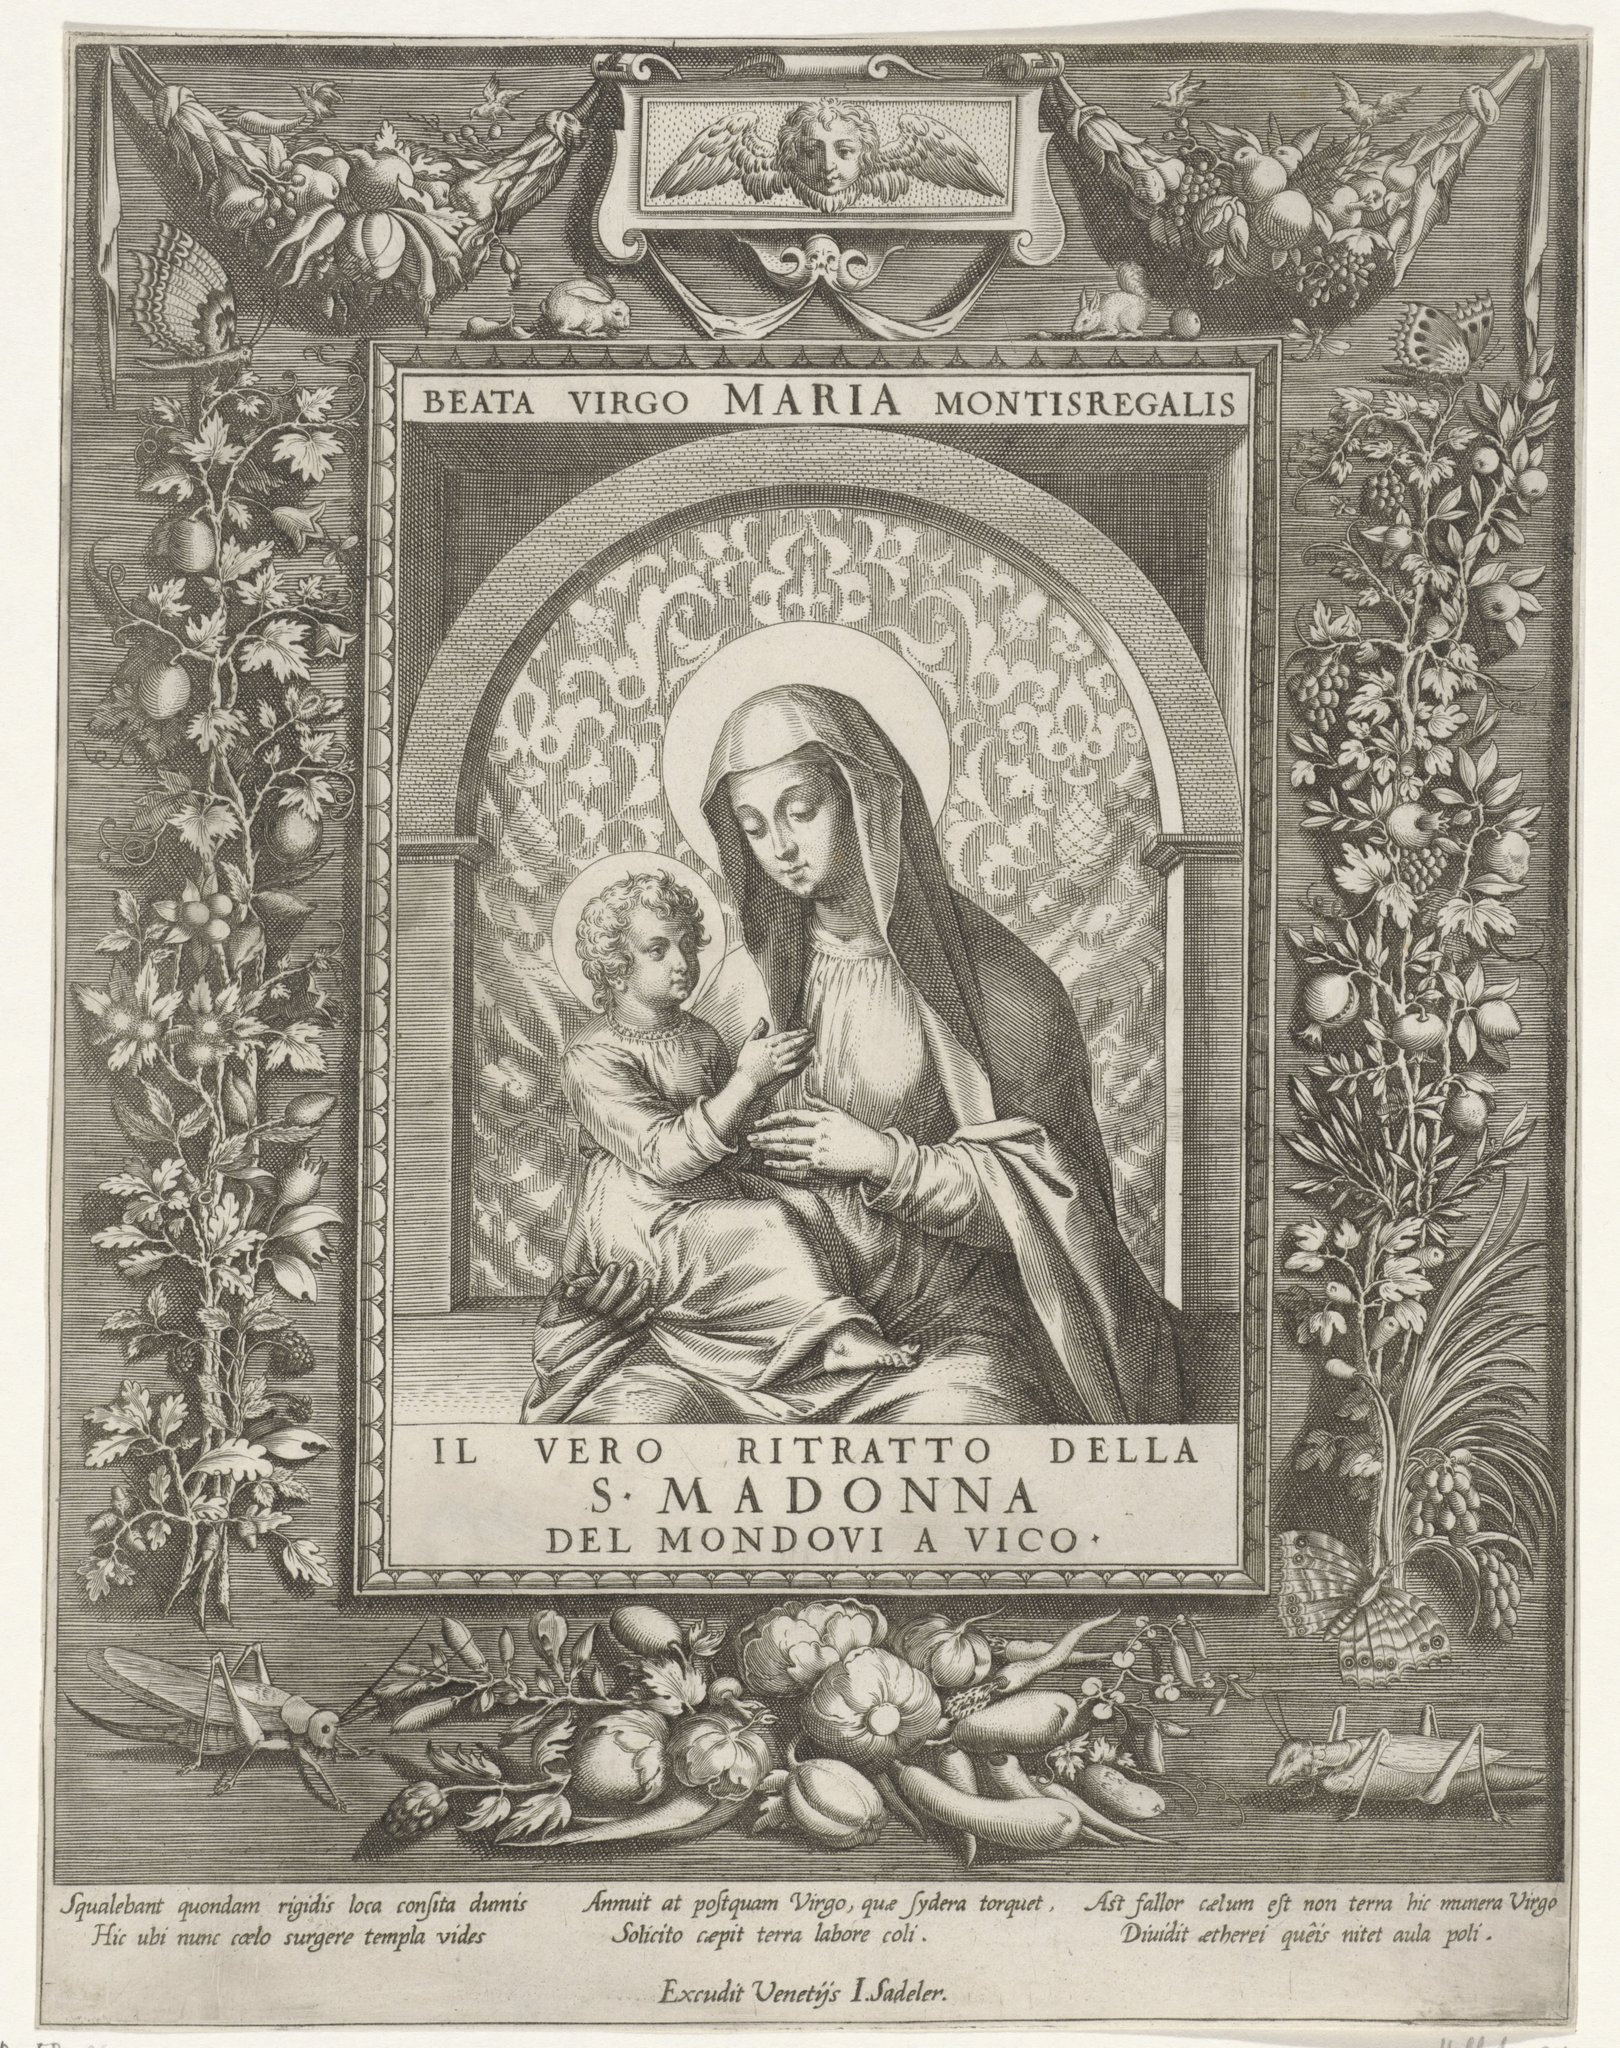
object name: print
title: Beata Virgo Maria Montisregalis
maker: johann sadeler (i)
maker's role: print maker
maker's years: 1550-1600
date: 1597-1599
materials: paper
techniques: engraving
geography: venice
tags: mary standing (or half-length), the christ-child sitting on her arm (christ-child to mary's left), ornament ~ festoon, garland, flowers ~ ornament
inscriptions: collector's mark: Lugt 240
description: De maagd Maria met het Chrituskind op de arm, in een nis. Het geheel in ornamentlijst met vogels en bloemen